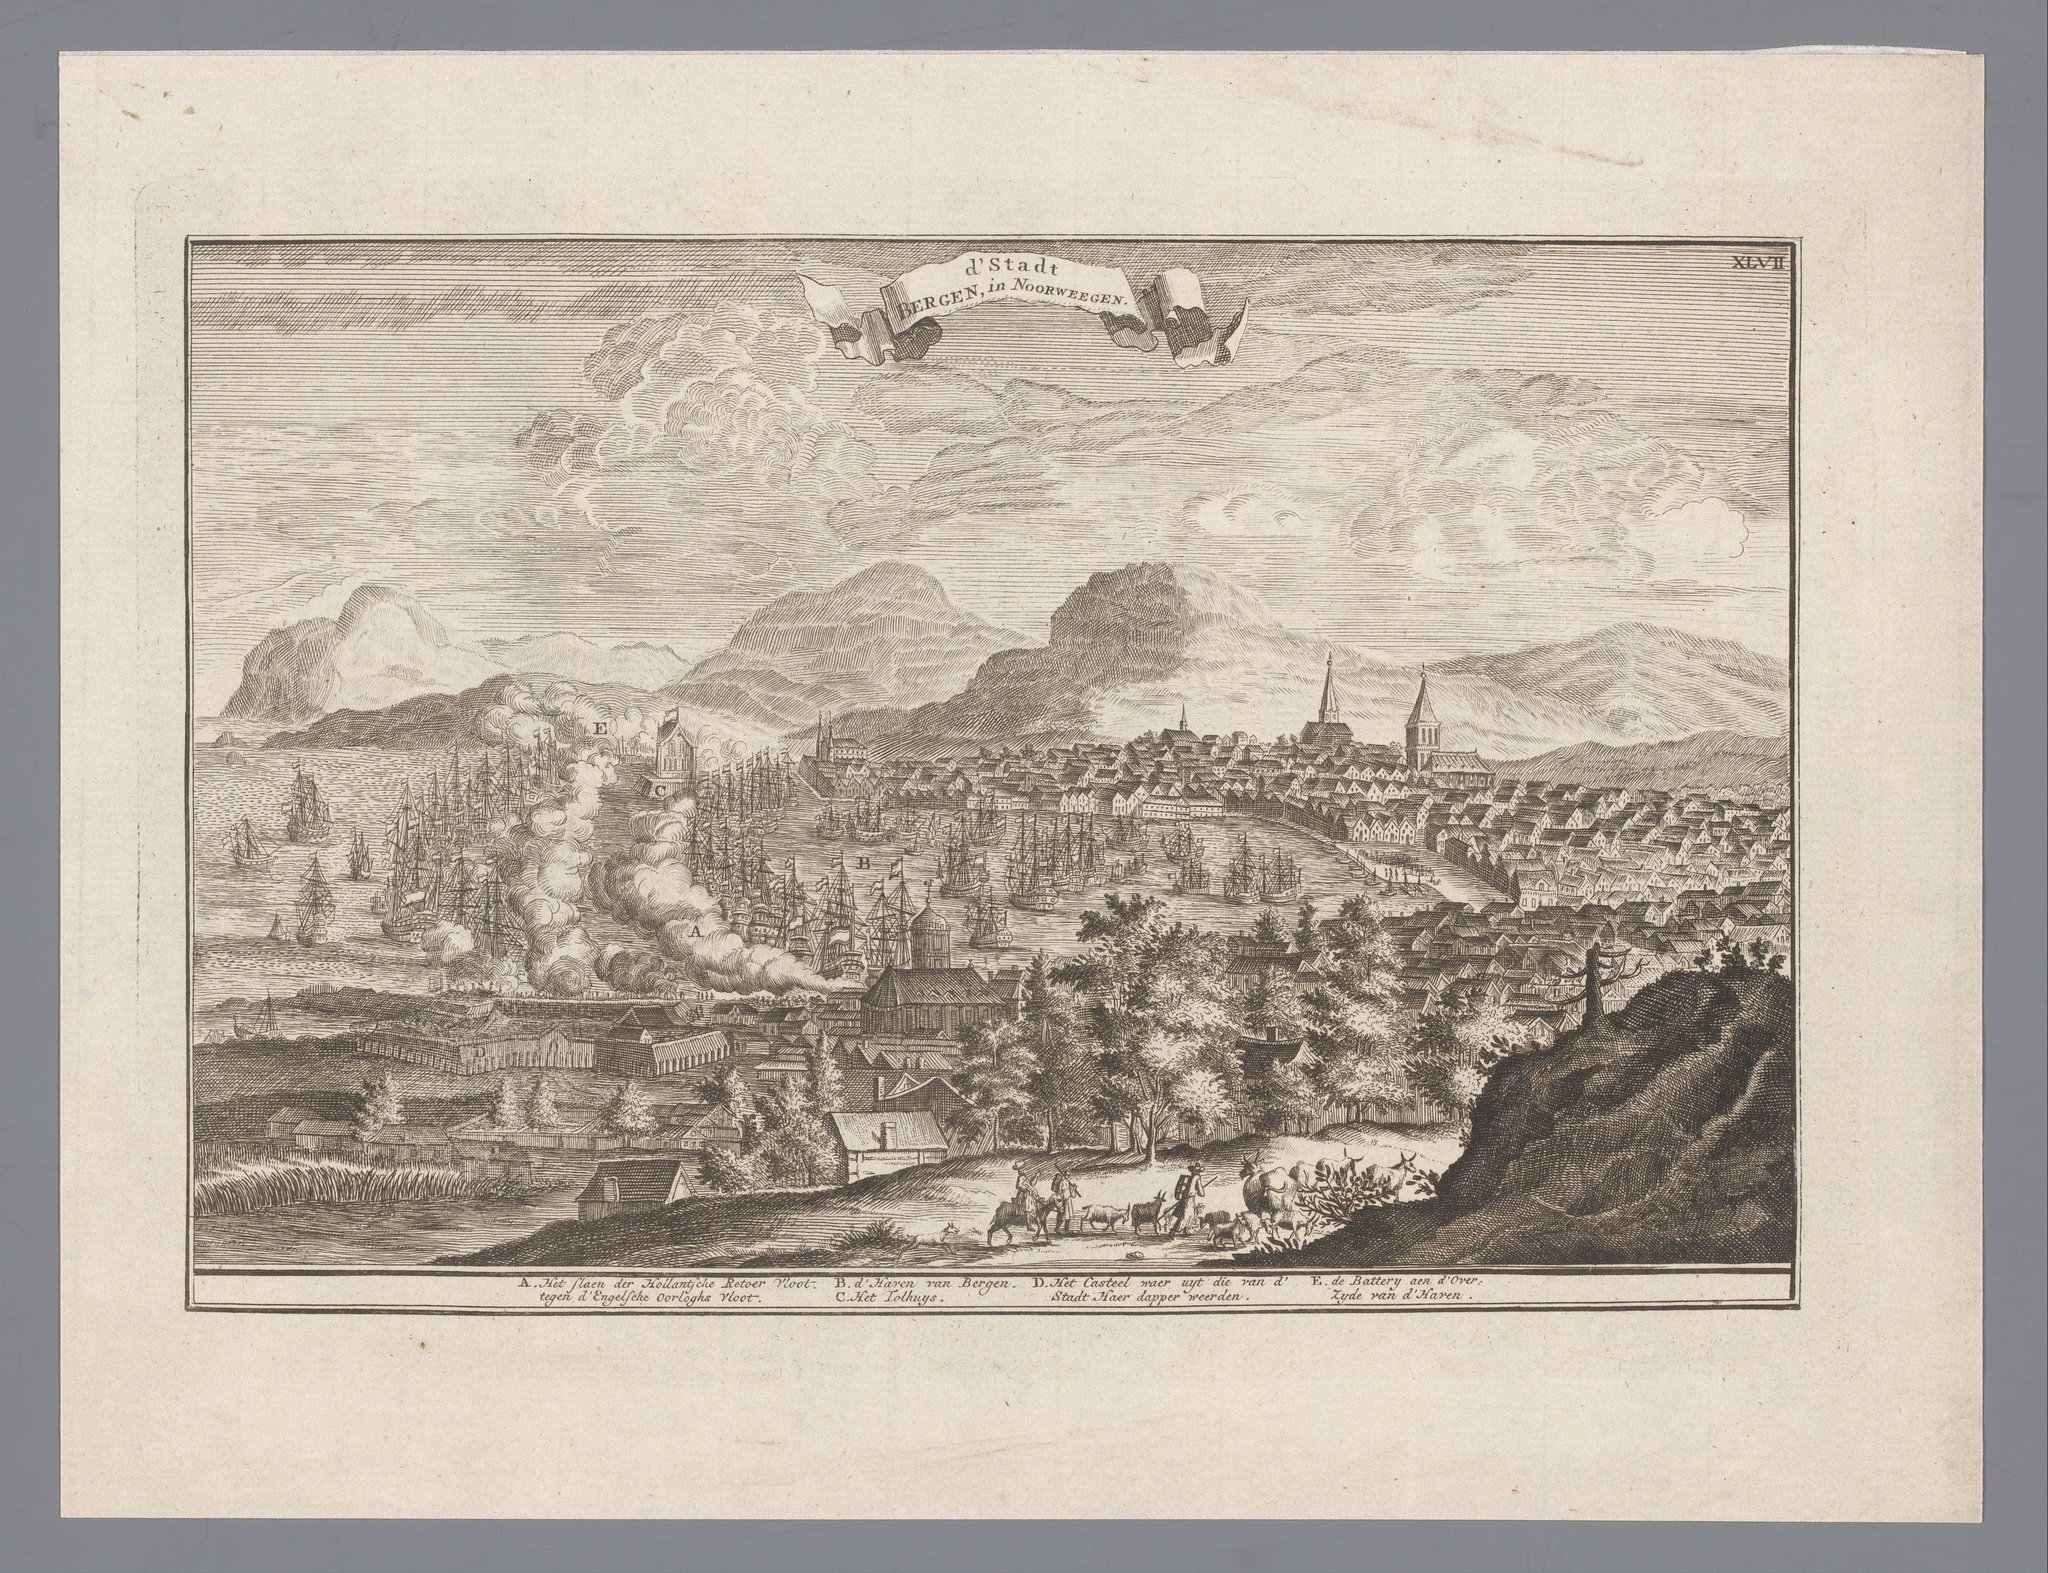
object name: history print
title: Hollandse koopvaardijschepen aangevallen in de haven van Bergen in Noorwegen, 1665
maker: Anonymous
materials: paper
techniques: engraving, etching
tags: battle (+ naval force)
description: Slag bij Bergen (Noorwegen), 10 augustus 1665. Aanval door de Engelse vloot op de Hollandse koopvaardijvloot gelegen in de neutrale haven van Bergen in Noorwegen. De Engelsen worden door De Ruyter verjaagd. In het onderschrift de legenda A-E. Rechtsboven genummerd: XLVII.